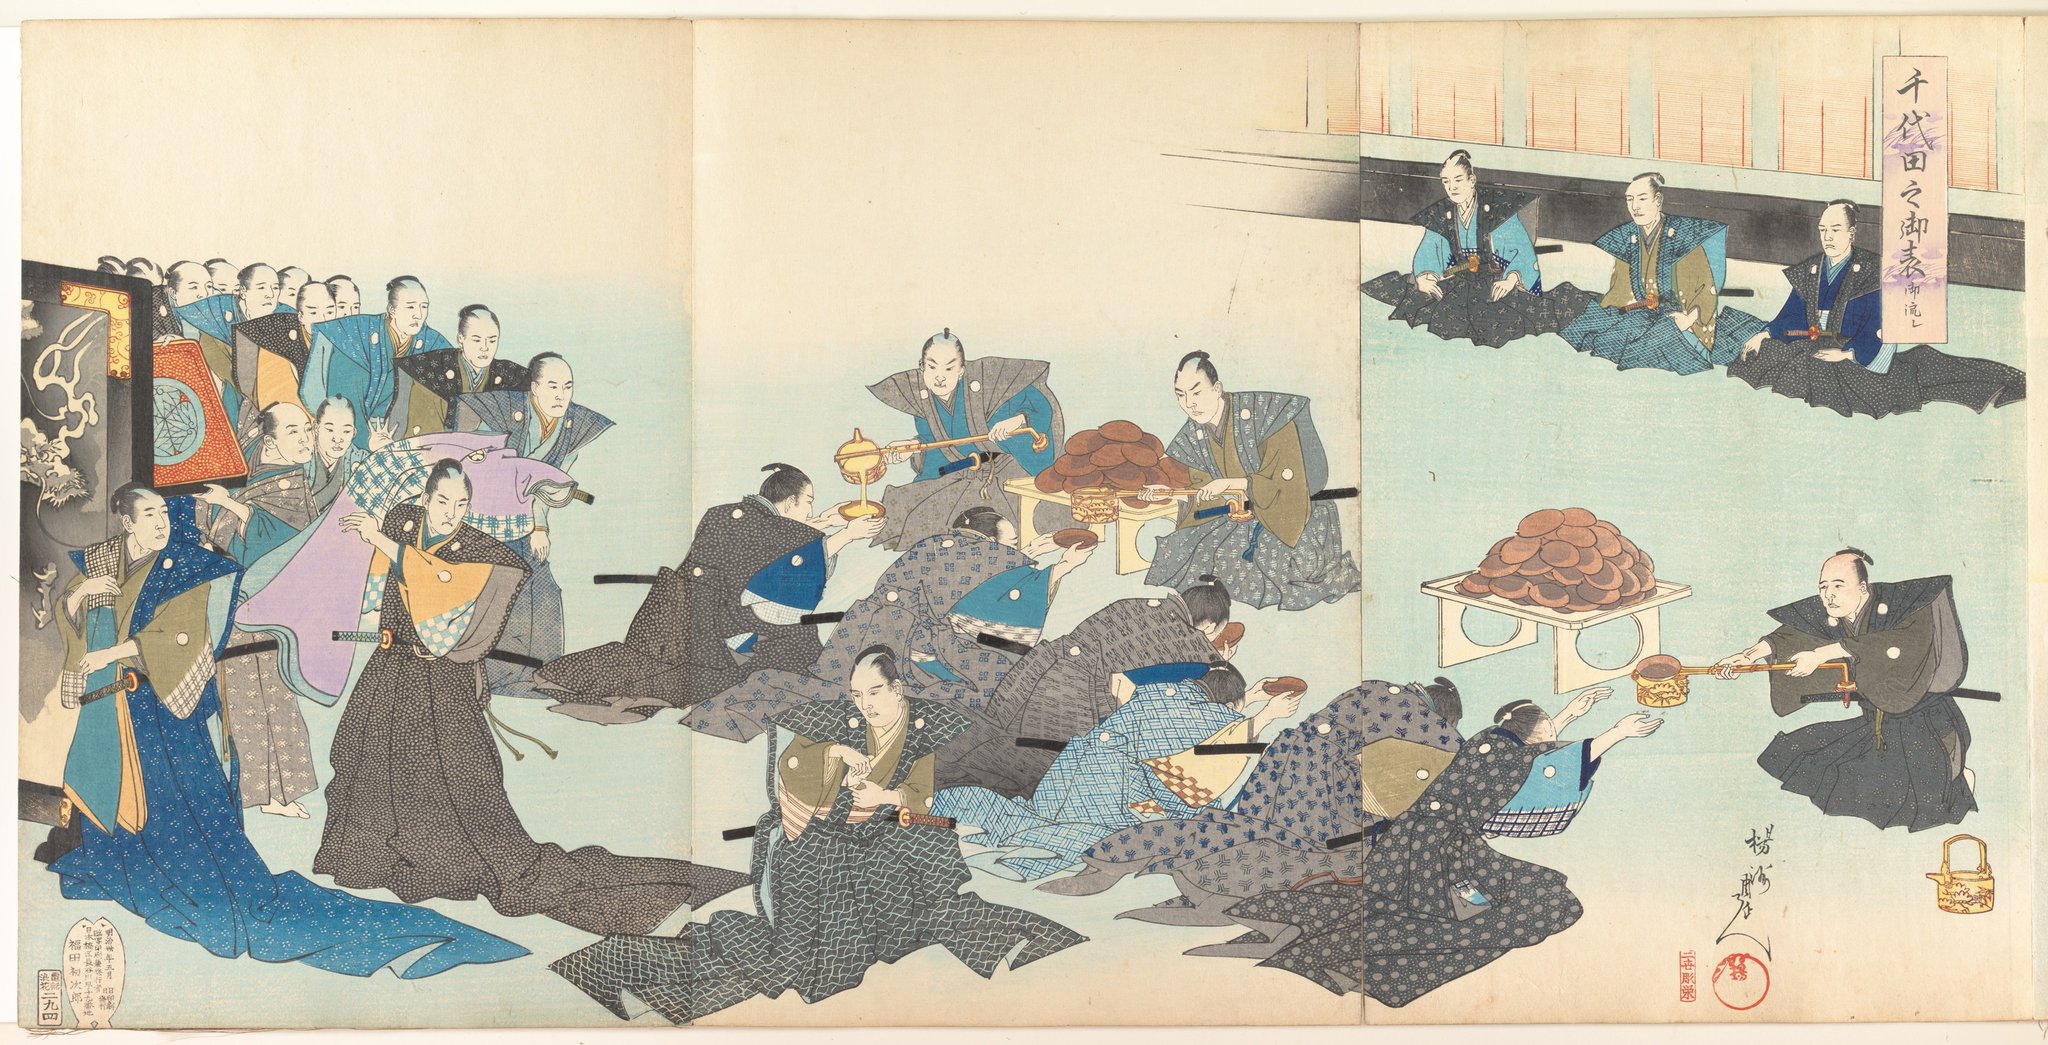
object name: print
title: Chiyoda Castle (Album of Men)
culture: japanese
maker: yōshū (hashimoto) chikanobu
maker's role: artist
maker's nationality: japanese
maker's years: 1838-1912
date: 1897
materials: ink, paper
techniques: woodblock print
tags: food,men,eating